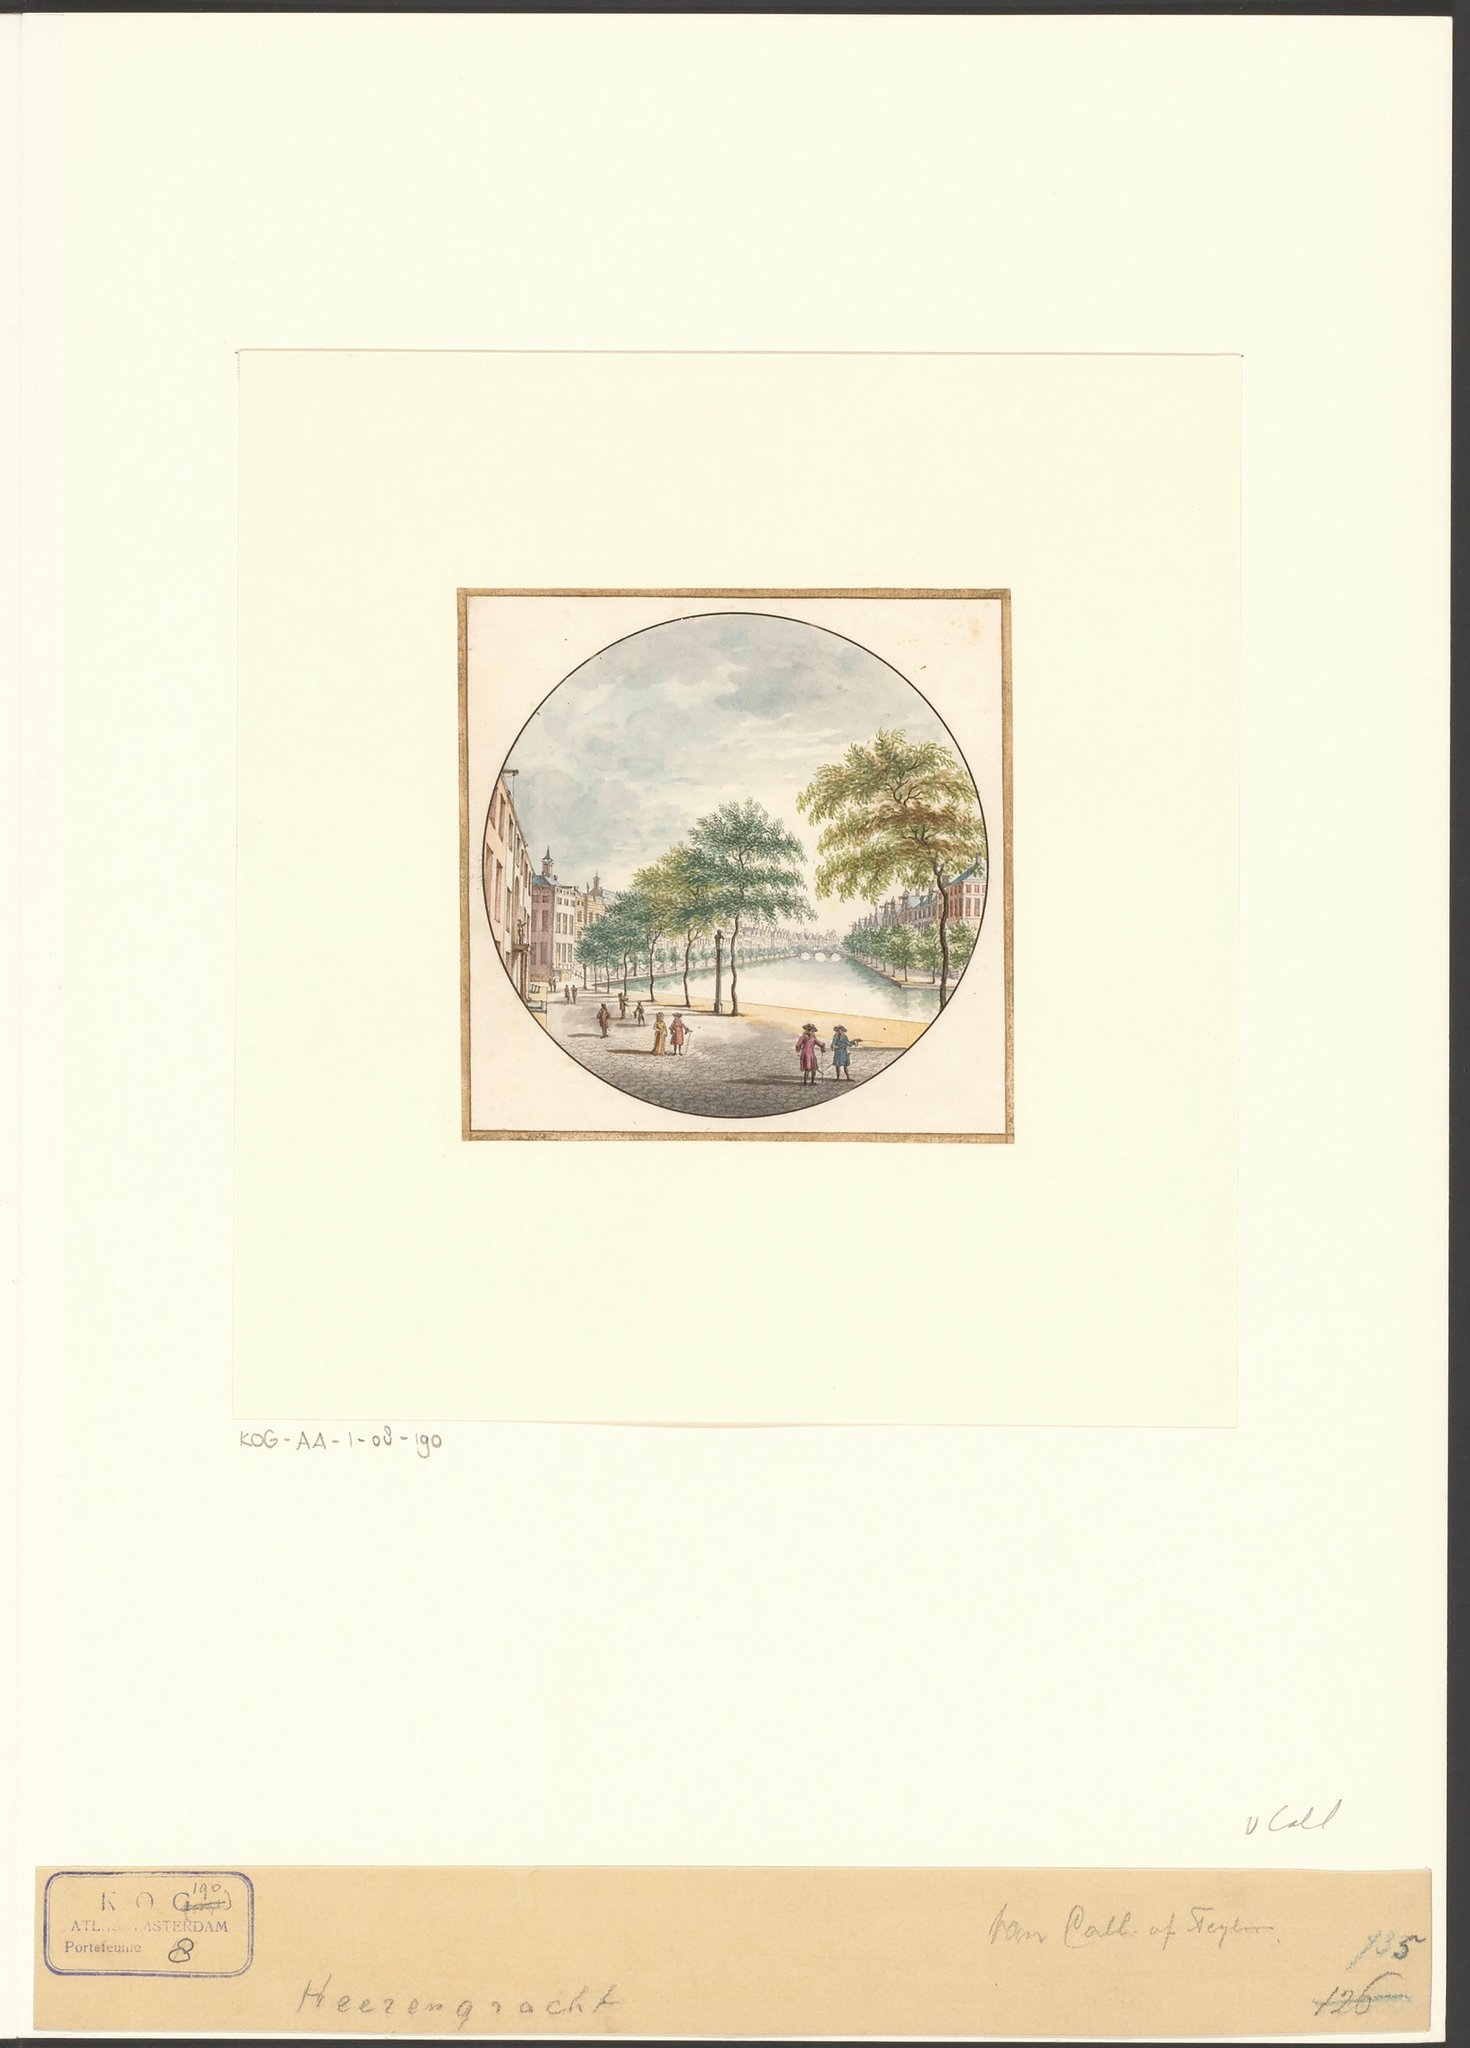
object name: drawing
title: Gezicht op de Herengracht, gezien vanaf de Vijzelstraat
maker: jan van call (i)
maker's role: draughtsman, print maker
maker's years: 1656-1706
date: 1699-1756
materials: paint, ink, paper, pencil, watercolor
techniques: brush, pen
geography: amsterdam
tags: city-view in general; 'veduta', canal, bridge in city across river, canal, etc., street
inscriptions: collector's mark: ‘8’ Lugt 1641b, inscription: ‘Heerengracht / van Call of [...]eyl[...]’, inscription: ‘Port. 8-190’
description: Onderwerpsrubriek binnen de Atlas Amsterdam: Haarlemmerplein, Halvemaansteeg, Handboogstraat, Handelskade, Haringpakkerij, Hartenstraat, Hasseltsteeg (Dirk van), Heerengracht.